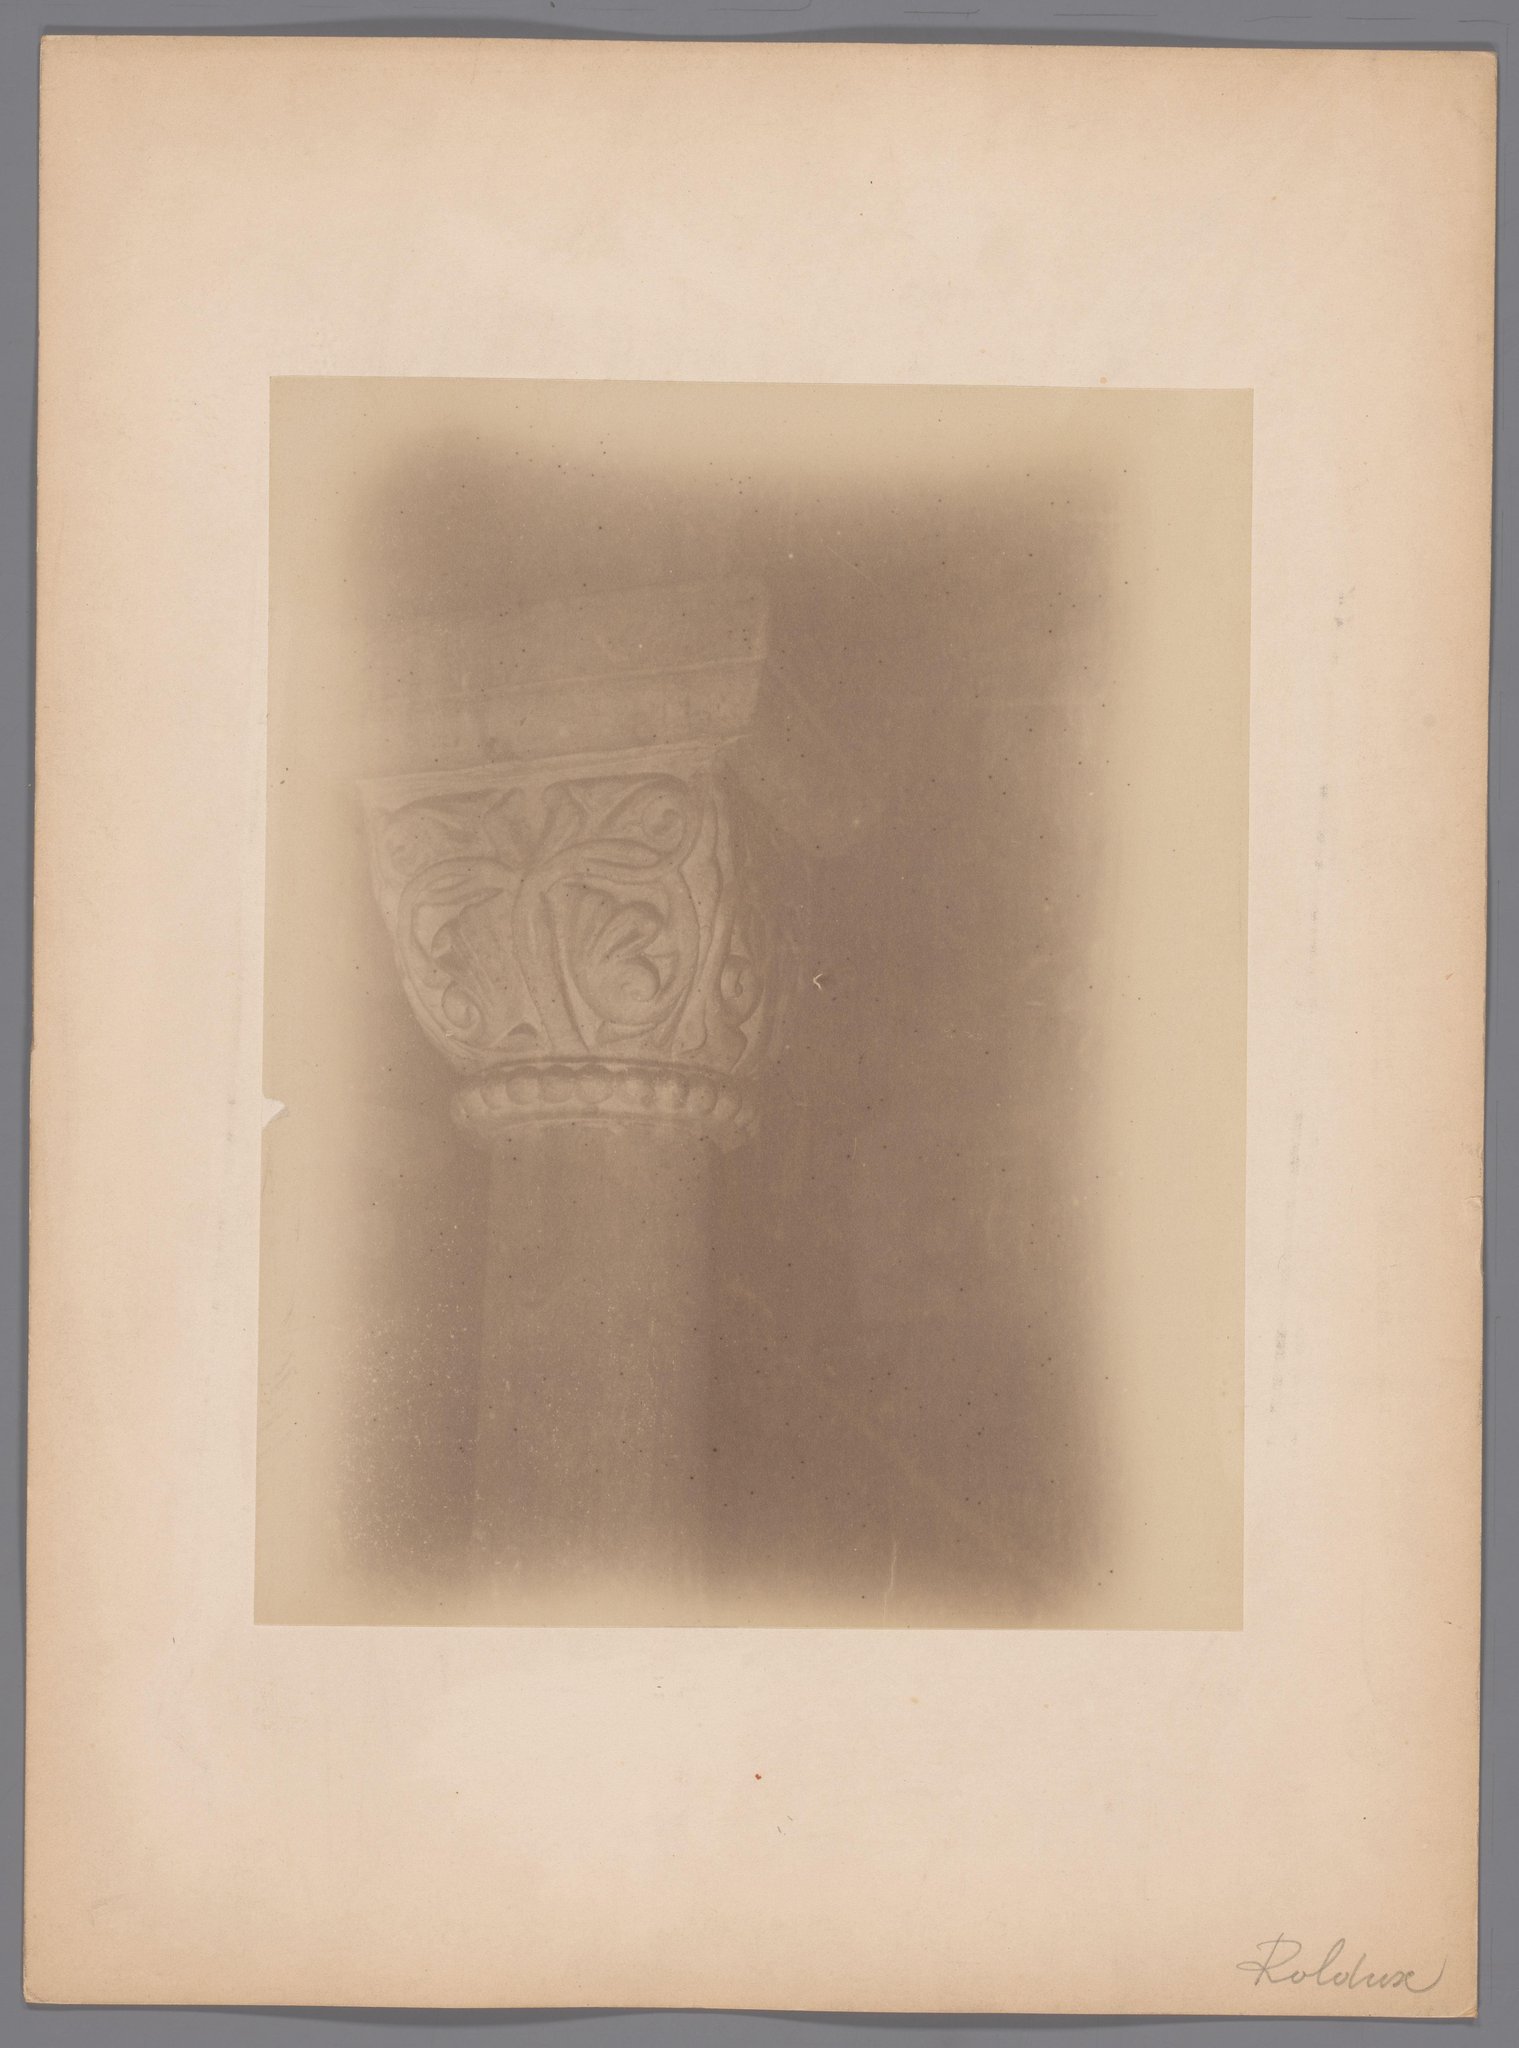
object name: photograph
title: Kapiteel van een kolom in crypte van de Abdijkerk te Rolduc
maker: anoniem (monumentenzorg)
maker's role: fotograaf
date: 1890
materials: cardboard, photographic support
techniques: albumen print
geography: rolduc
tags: capital (~ column, pillar), parts of church interior (crypt)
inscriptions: annotation: ‘Rolduc’, annotation: ‘Kapiteel van een der kolommen in de Krypte der kerk te Rolduc/ oct 1980’